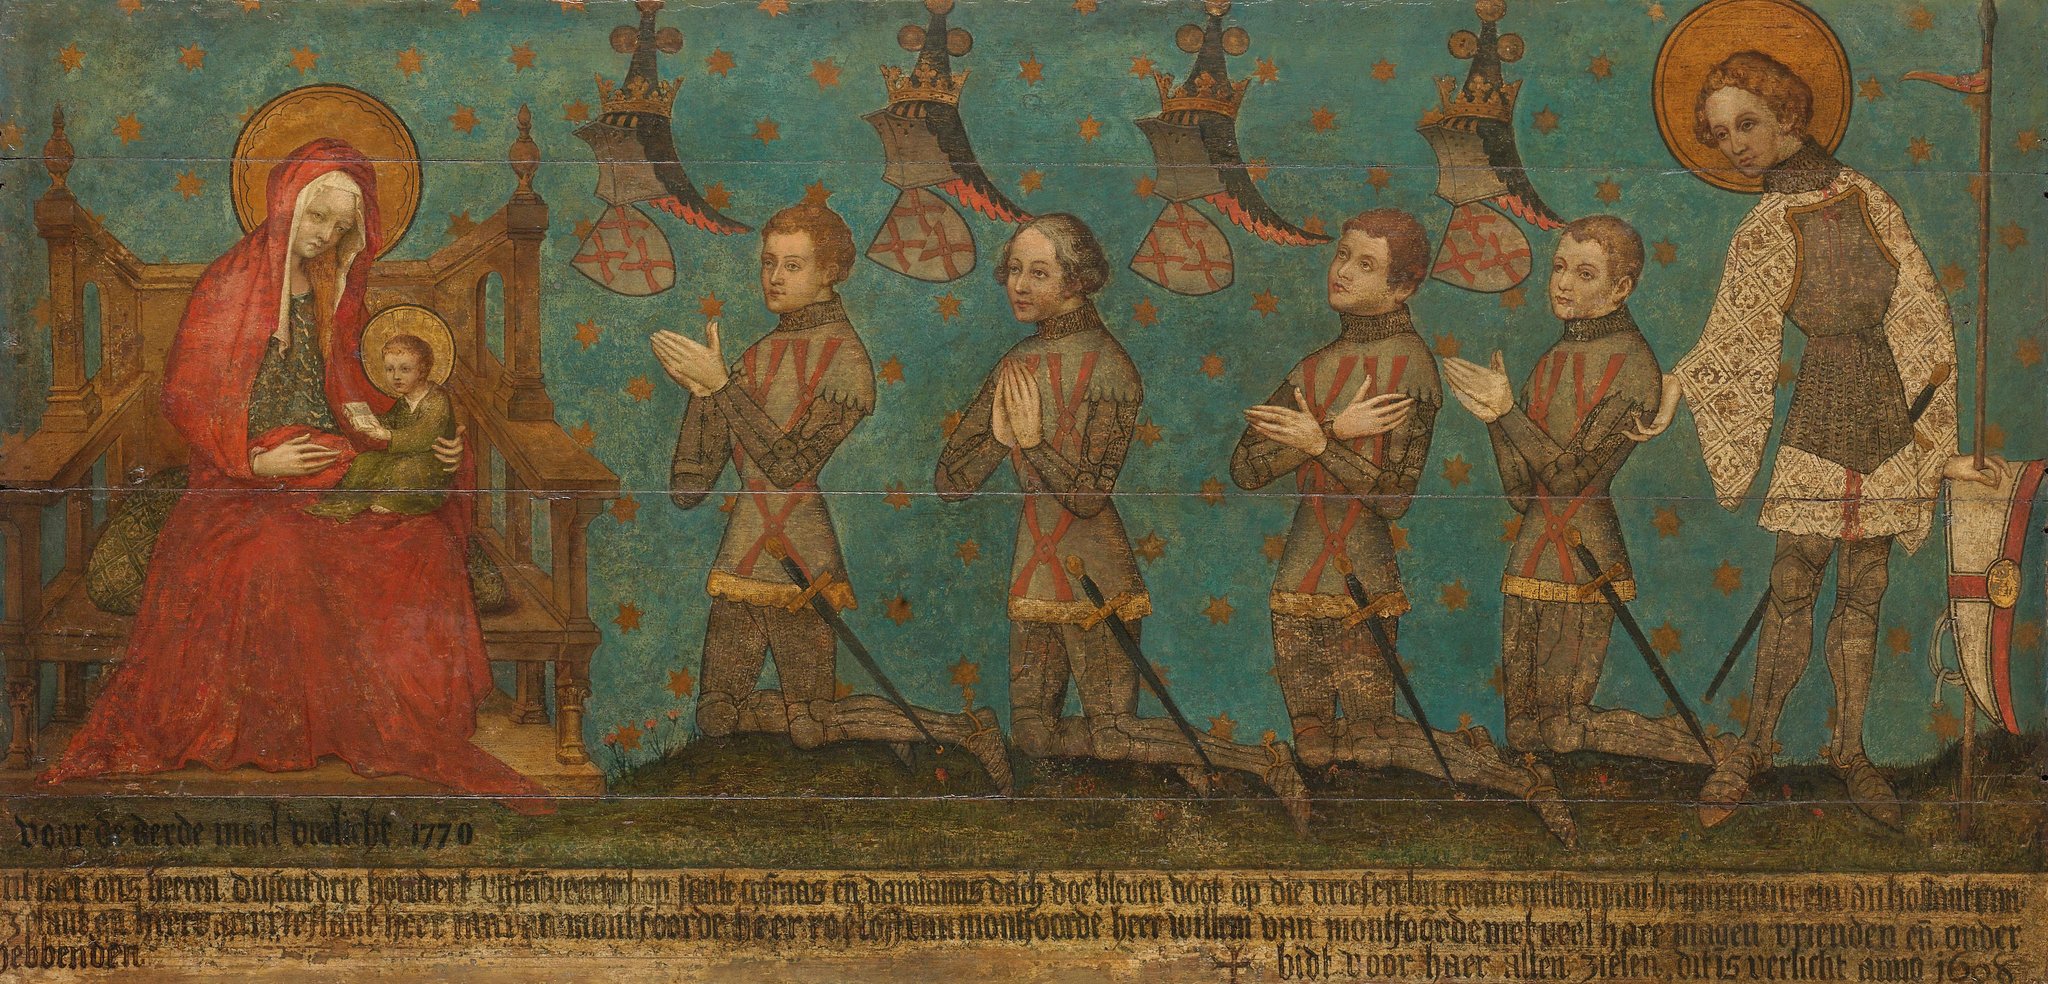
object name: painting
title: The Lords of Montfoort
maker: Anonymous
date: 1400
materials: oil, paint, panel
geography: northern netherlands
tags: the warrior martyr george (georgius); possible attributes: banner (red cross on white field), (red) cross, dragon, (white) horse, broken lance, shield (with cross), sword, knight, mary sitting or enthroned, the christ-child on her knee (christ-child to mary's left)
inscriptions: inscription, bottom: ‘int jaer ons heeren dusent drie hondert vijf en veertich op sante cosmas en damianus dach doe bleven doot op die vriezen bij grave willem van heynegouwen van hollant en van Zeland en heer van Vrieslant heer jan van Montfoorde heer roeloff van Montfoorde heer willem van Montfoorde met veel hare magen vrienden en onderhebbenden. Bidt voor haer allen zielen. // dit is verlicht anno 1608; voor de derde maal verlicht 1770’ (in the year of Our Lord 1345, on Sts Cosmas and Damian’s Day, killed by the Frisians along with Count Willem of Hainaut, Holland and Zeeland, and Lord of Friesland: Lord Jan van Montfoort, Lord Roelof van Montfoort, Lord Willem van Montfoort, with many of their kin, friends and subordinates. Pray for all their souls. This was portrayed in the year 1608; portrayed for the third time in 1770), coat of arms, top: three red mill-irons on a silver field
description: Four Dutch knights kneel before the Virgin. The first three died in 1345 in the Battle of Warns against the Frisians; the fourth was badly wounded. Behind them stands Saint George, their patron saint. The coats of arms above them show that they belong to the De Rover family of Montfoort. The painting is a ‘commemorative panel’ to honour their memory.